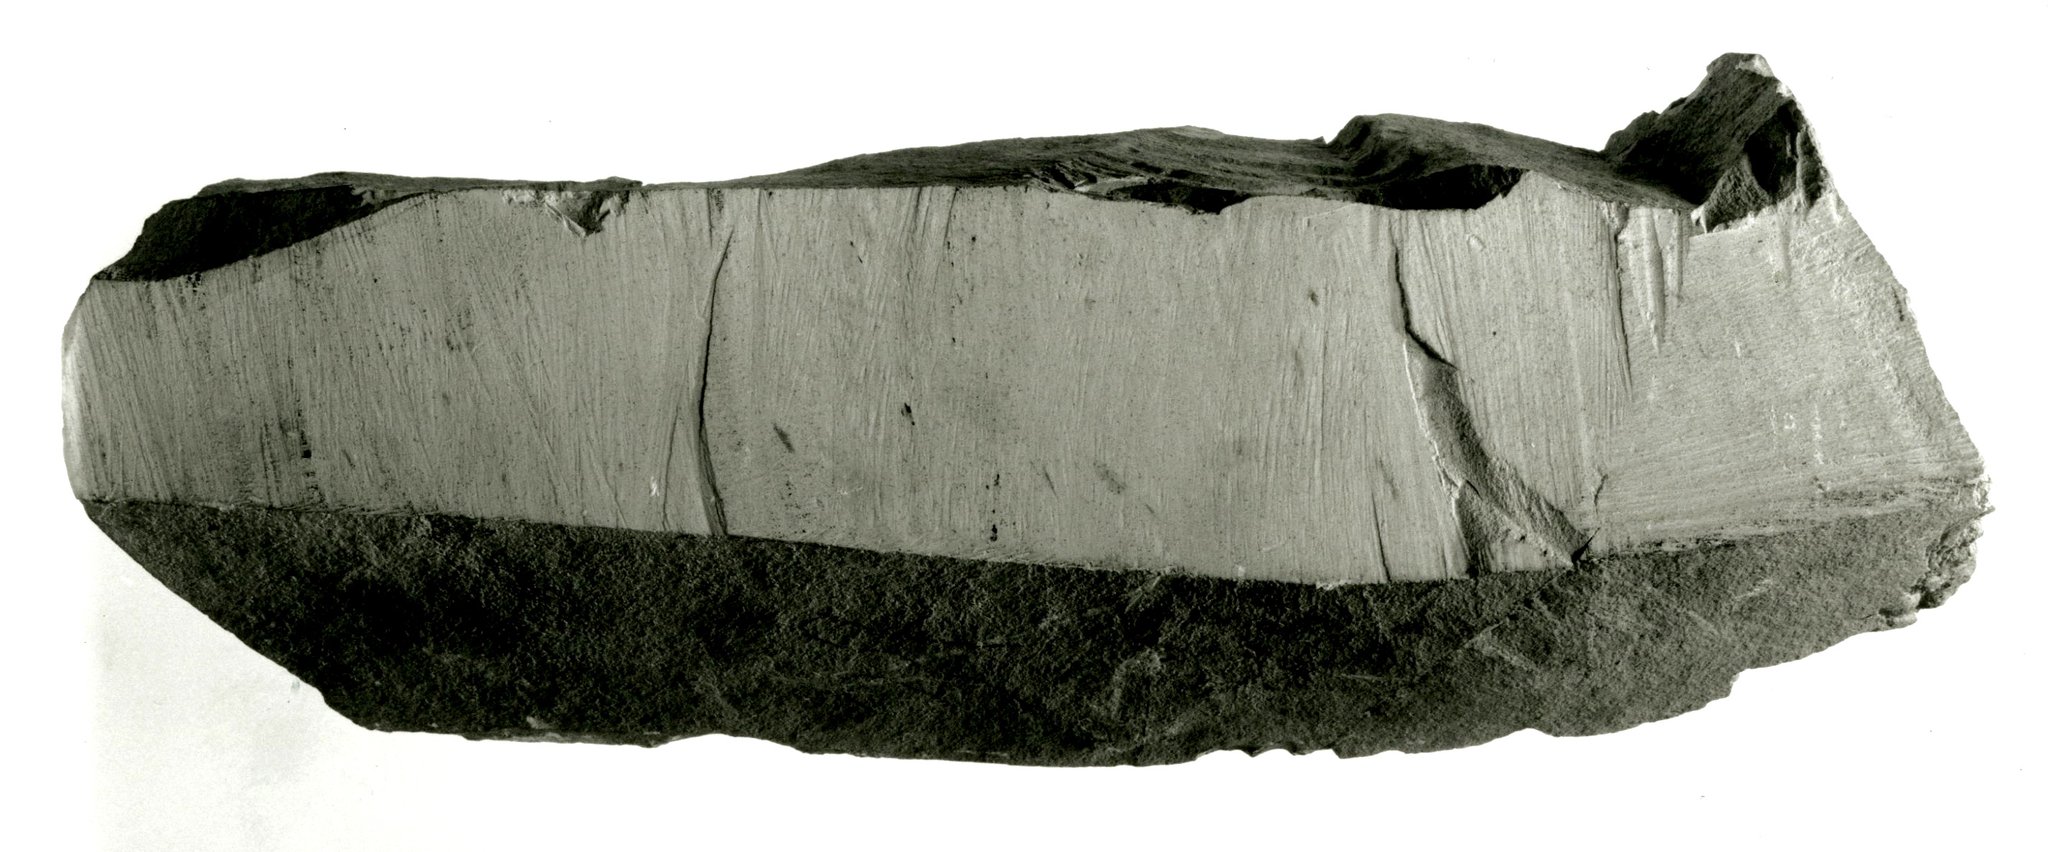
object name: relief, tomb of nespekashuty, wall casing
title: Wall casing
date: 664-610 BCE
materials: limestone, mortar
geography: egypt